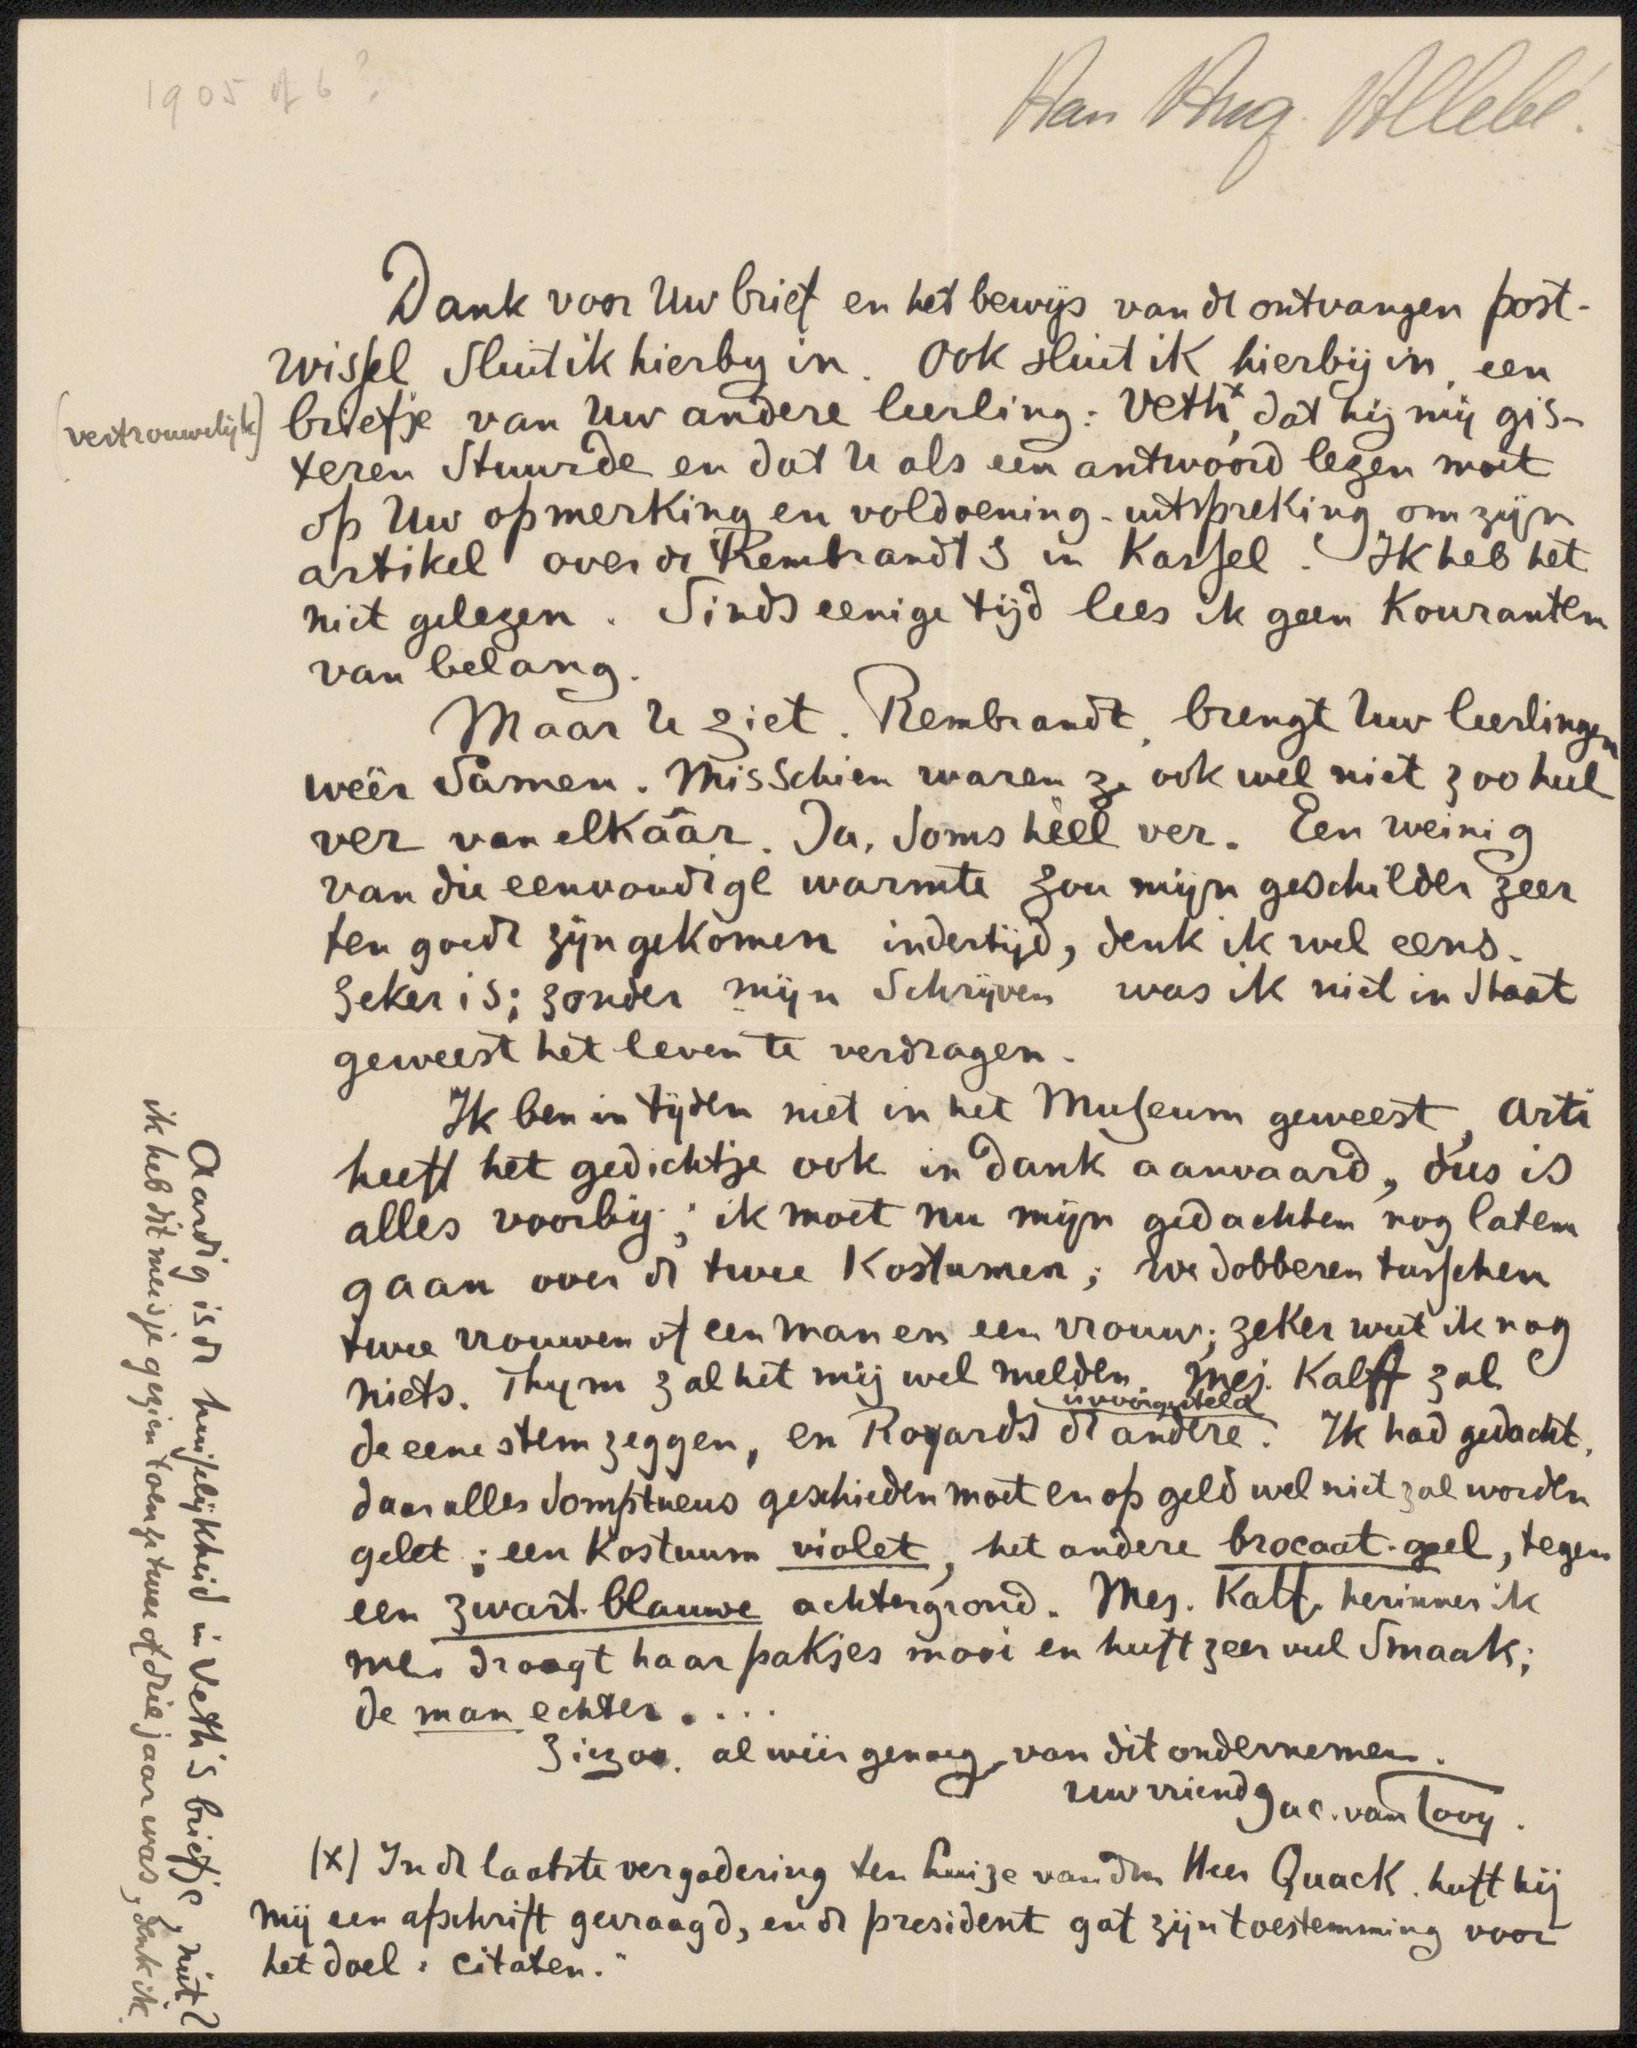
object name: letter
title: Brief aan onbekend, mogelijk August Allebé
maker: jac van looij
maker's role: draughtsman, painter, print maker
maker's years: 1855-1930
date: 1865-1930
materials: ink, paper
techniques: pen, writing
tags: dordrecht, designer, jan veth, leiden, amsterdam, painter, print maker, draughtsman, rembrandt van rijn, publisher, josephus albertus alberdingk thijm, hendrick peter godfried quack, willem cornelis royaards, paris, literature ~ arts, painting (including book-illumination, miniature-painting)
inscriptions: collector's mark: ‘RPK’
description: Brief bevat aantekening 'Aan Aug. Allebé' en 1906 of '6 in latere handen.